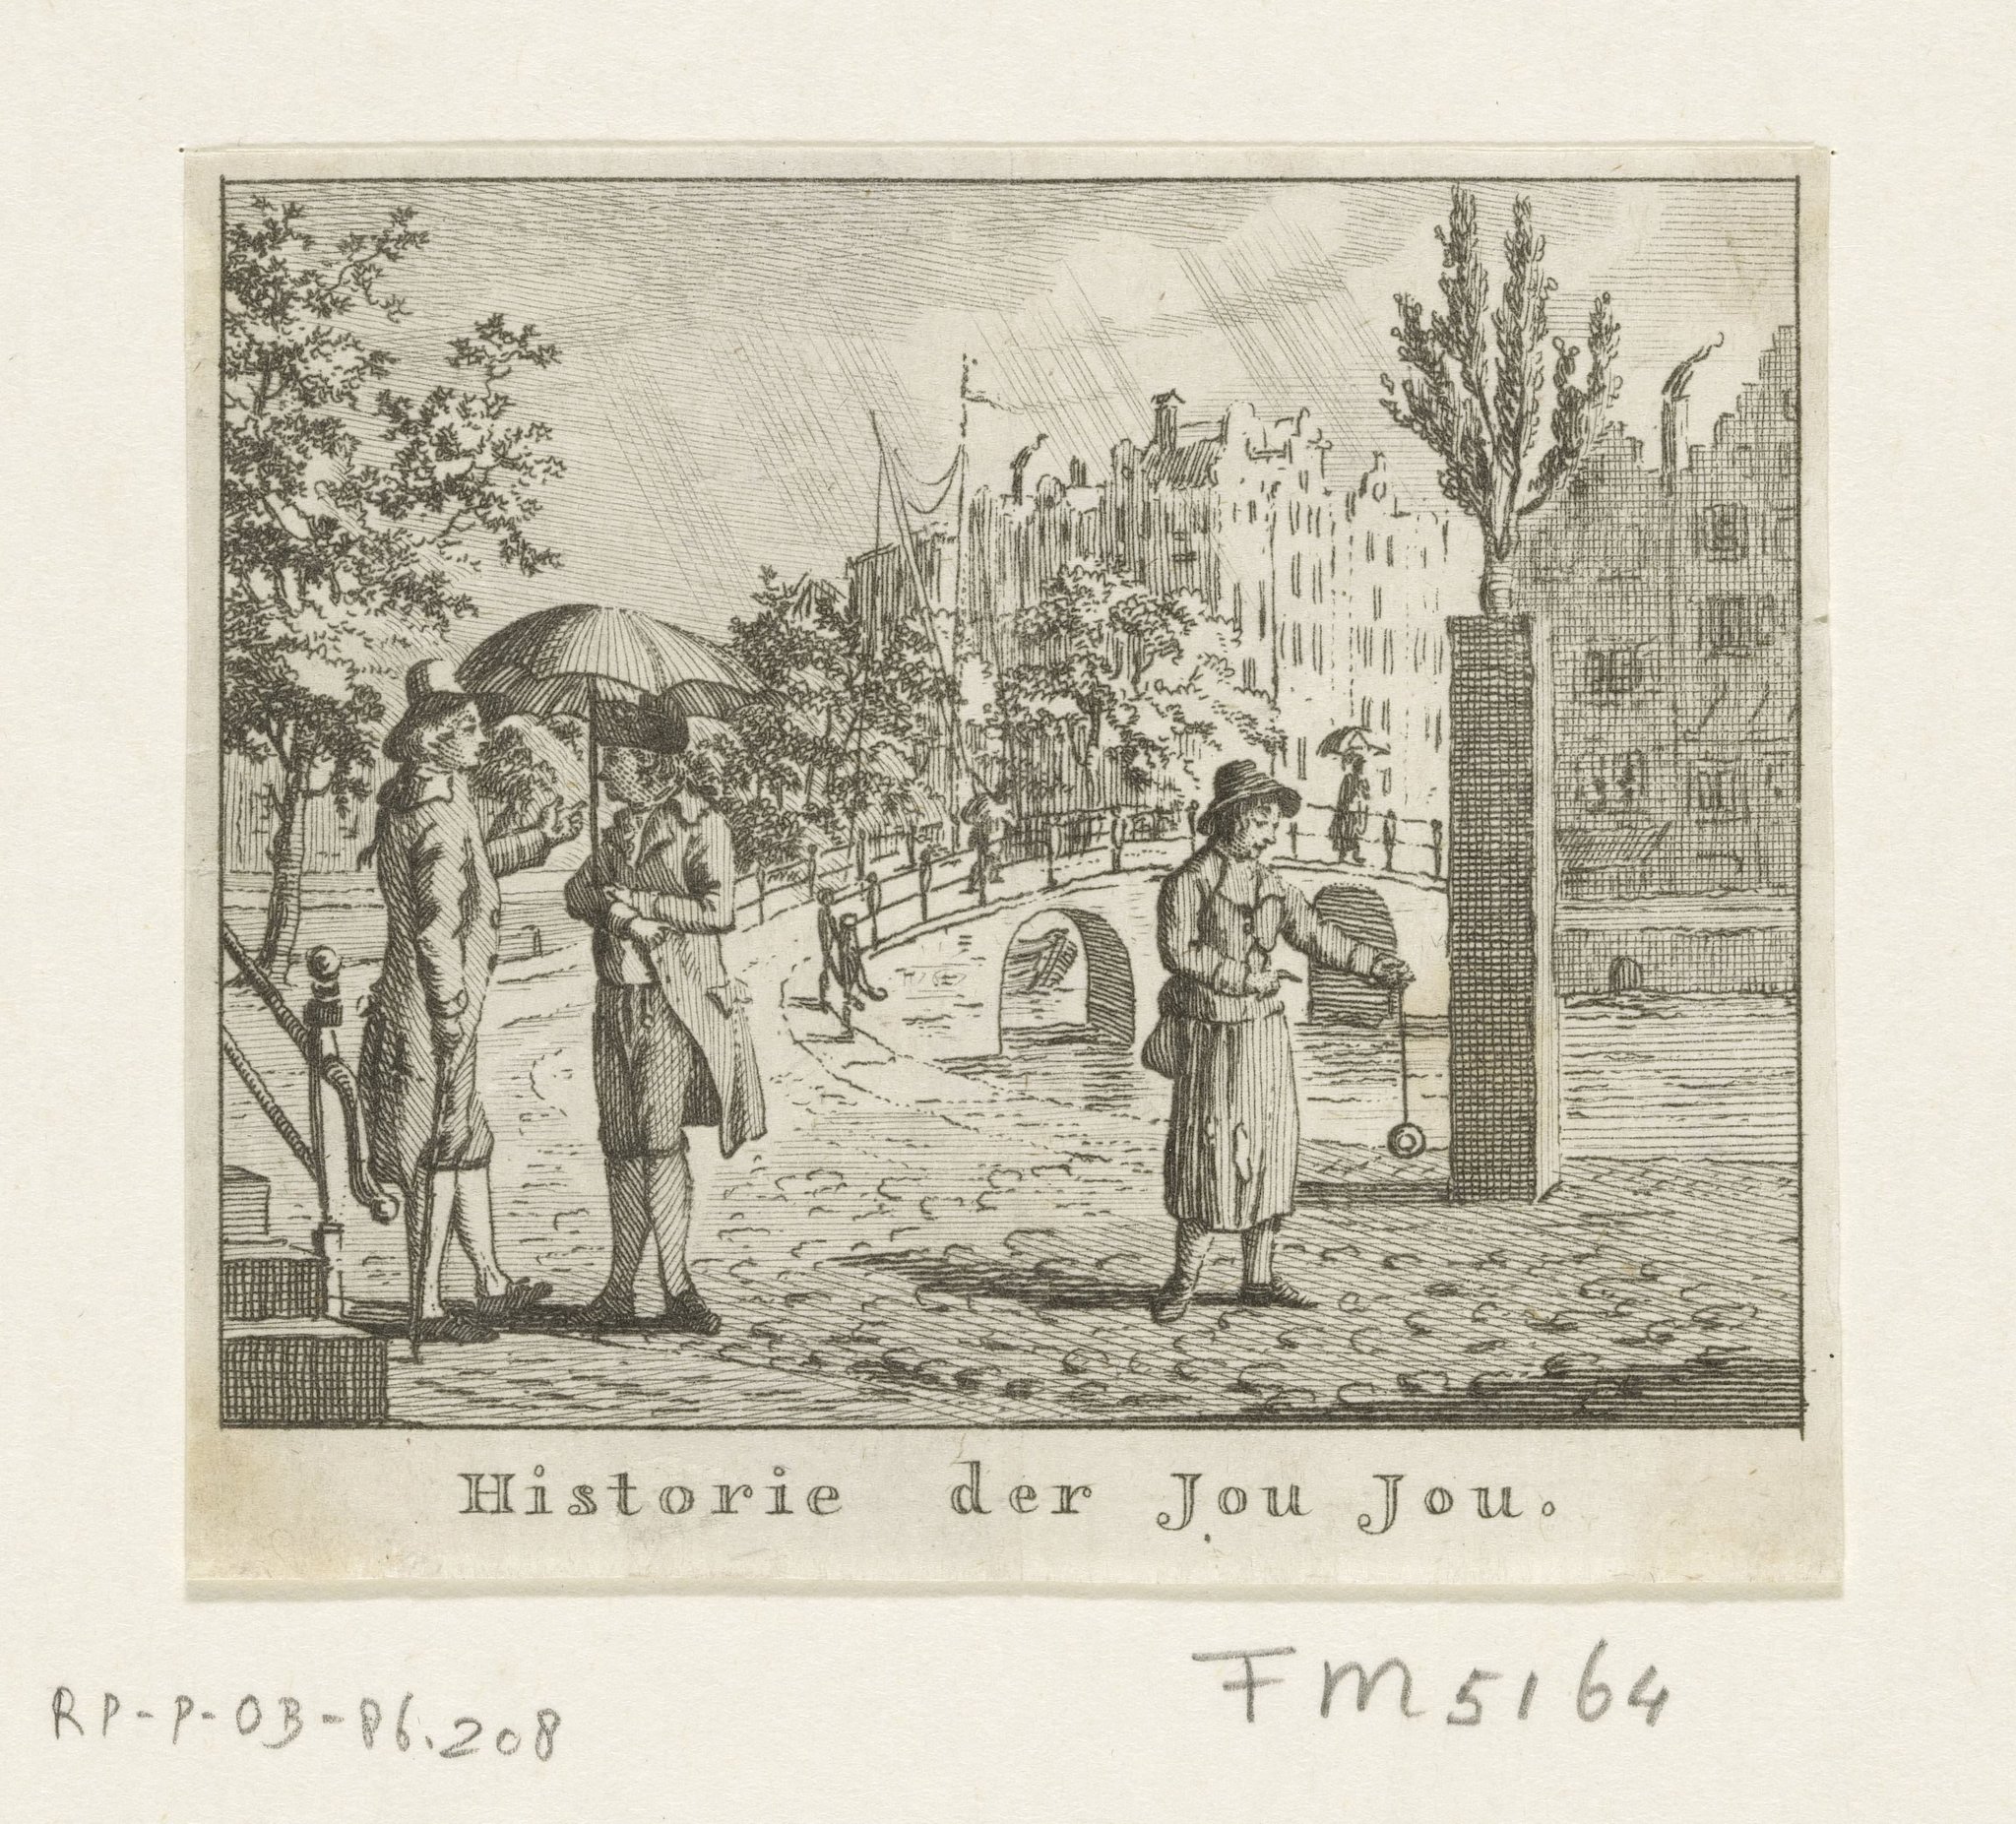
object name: print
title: Historie der Jou Jou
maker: Anonymous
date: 1791-1792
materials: paper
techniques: engraving, etching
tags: yoyo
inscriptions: collector's mark: Lugt 2228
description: Populariteit van de jojo, ca. 1791. Een jongen speelt op straat met een jojo.